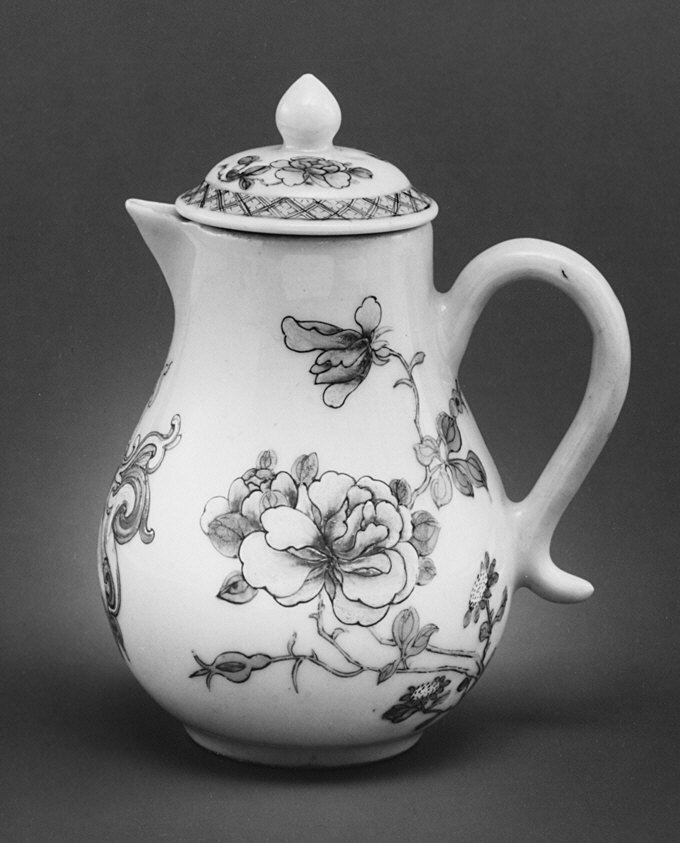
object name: cream jug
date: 1730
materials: hard paste porcelain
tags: flowers